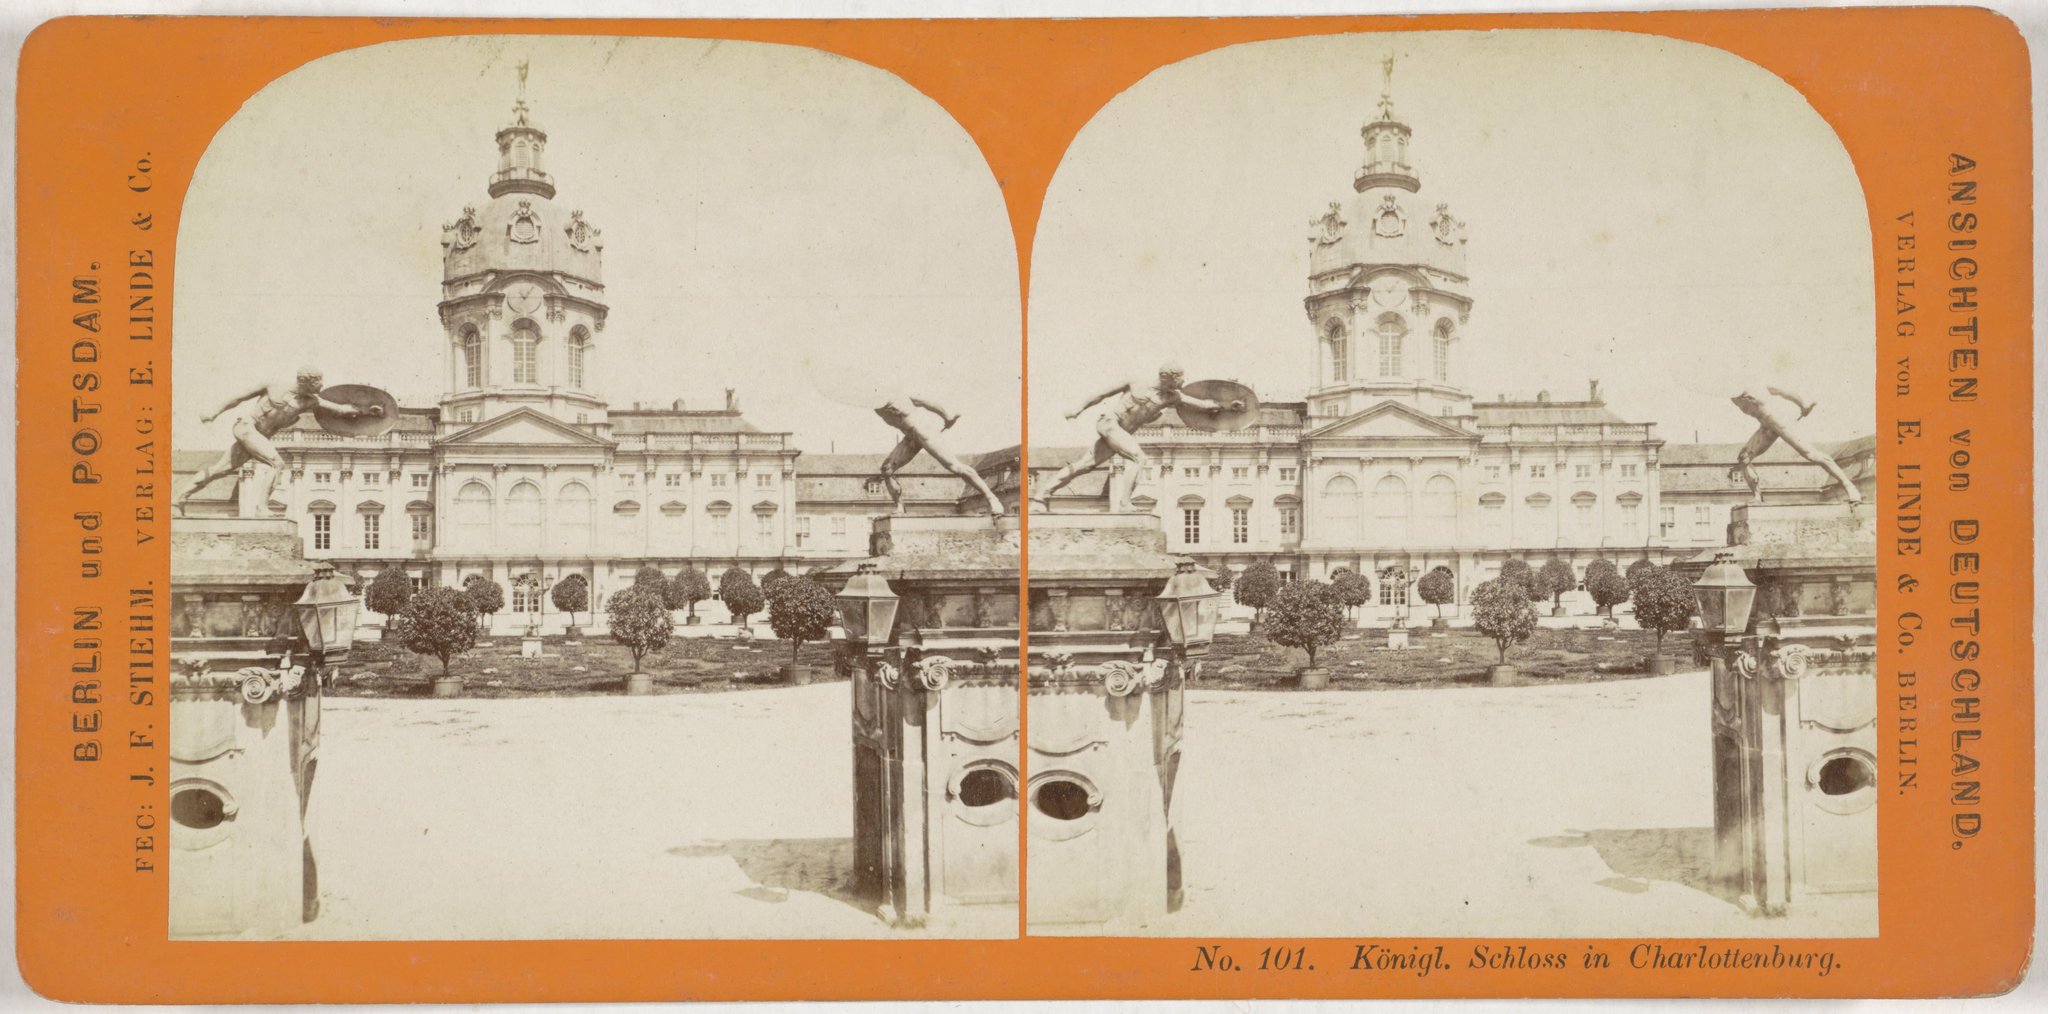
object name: stereograph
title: Ansichten von Deutschland / Berlin und Potsdam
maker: johann friedrich stiehm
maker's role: fotograaf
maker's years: 1826-1902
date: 1868-1870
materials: cardboard, paper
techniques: albumen print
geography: berlin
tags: palace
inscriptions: number: ‘No. 101’